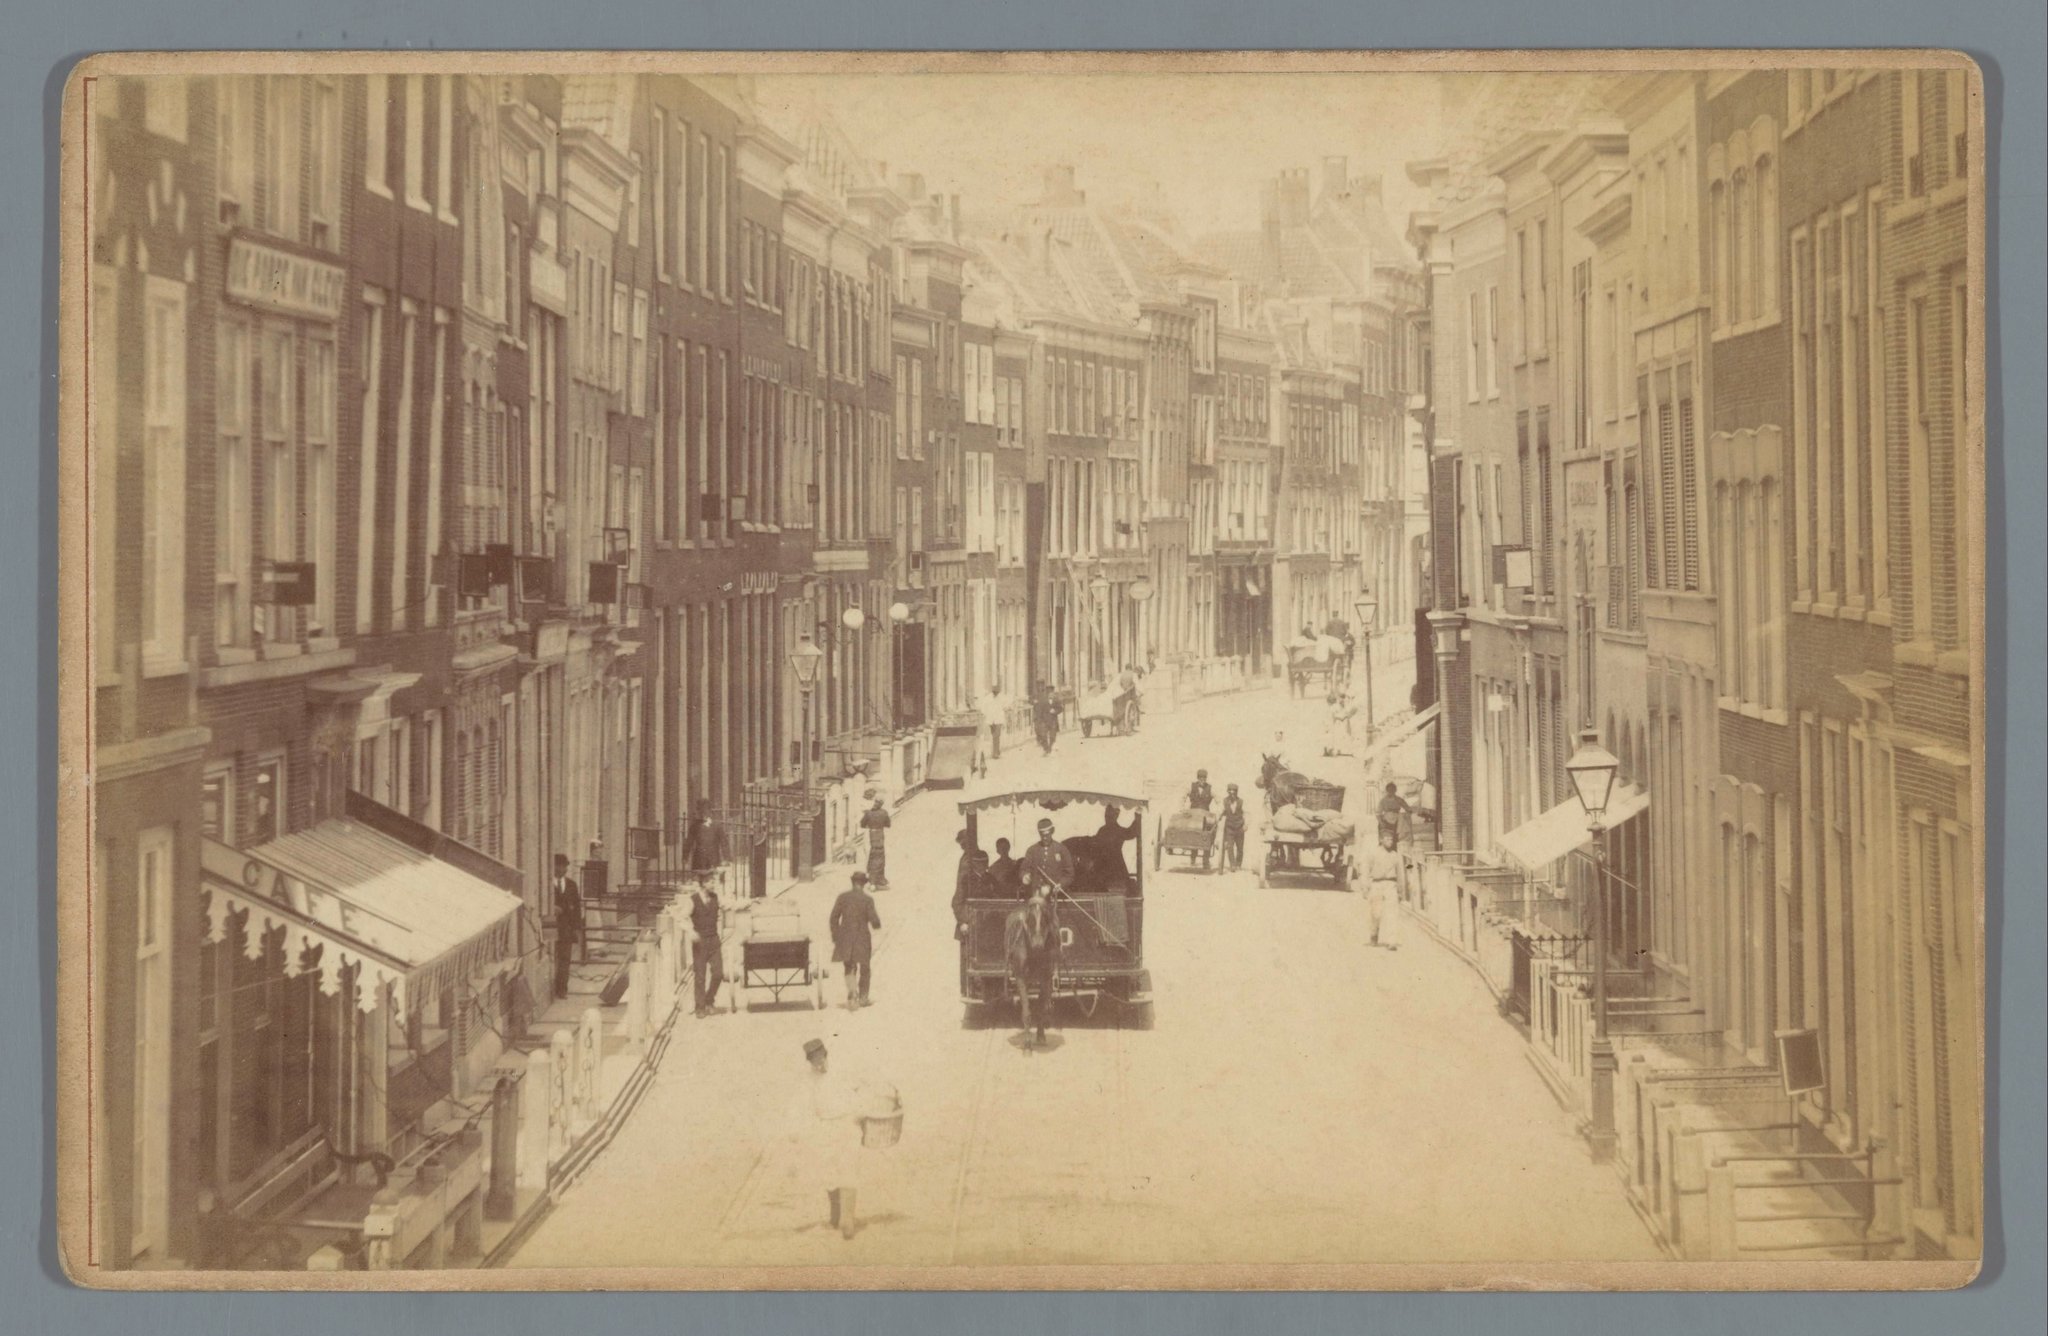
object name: cabinet photograph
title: Gezicht op de Breestraat te Leiden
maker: jan goedeljee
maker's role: fotograaf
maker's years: 1824-1905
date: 1850-1900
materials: cardboard, photographic support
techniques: albumen print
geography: leiden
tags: diligence, omnibus, horse-tram, city-view in general; 'veduta'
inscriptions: retailer's mark: ‘J. GOEDELJEE/ PHTOGRAAF/ VAN/Z.K.H. PRINS ALEXANDER/ der Nederlanden/ PRINS van ORANJE./ LEIDEN,/ HOOGEWOERD 160./ nabij de Plantage.’